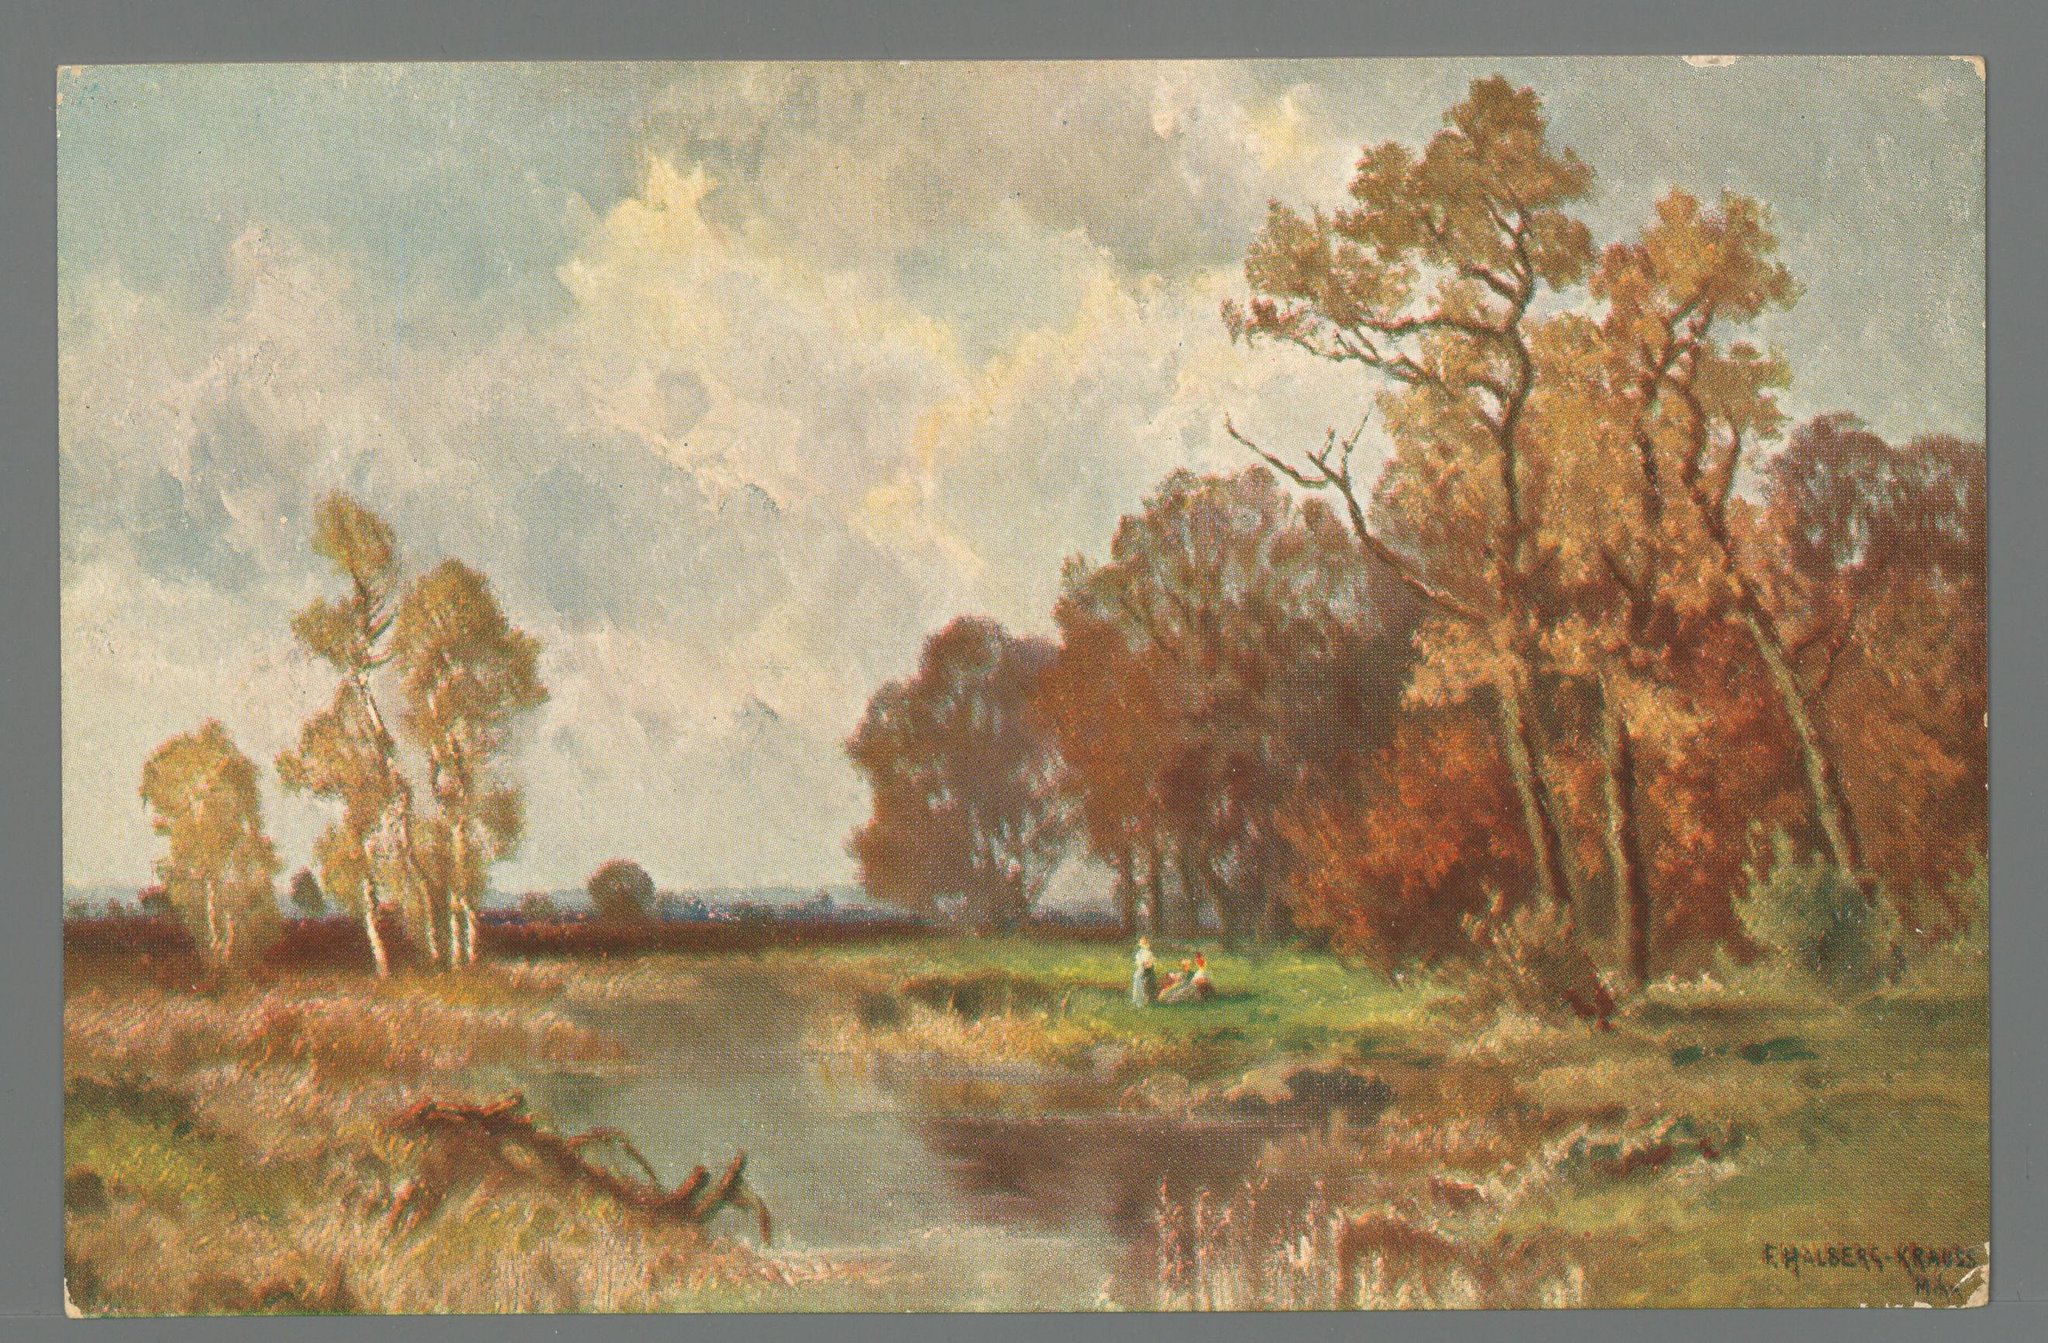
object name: reproduction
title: Halberg-Krauss "Freisinger Moos"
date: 1905-1930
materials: cardboard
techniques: color autotype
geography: munich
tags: swamp, inland marsh, fens